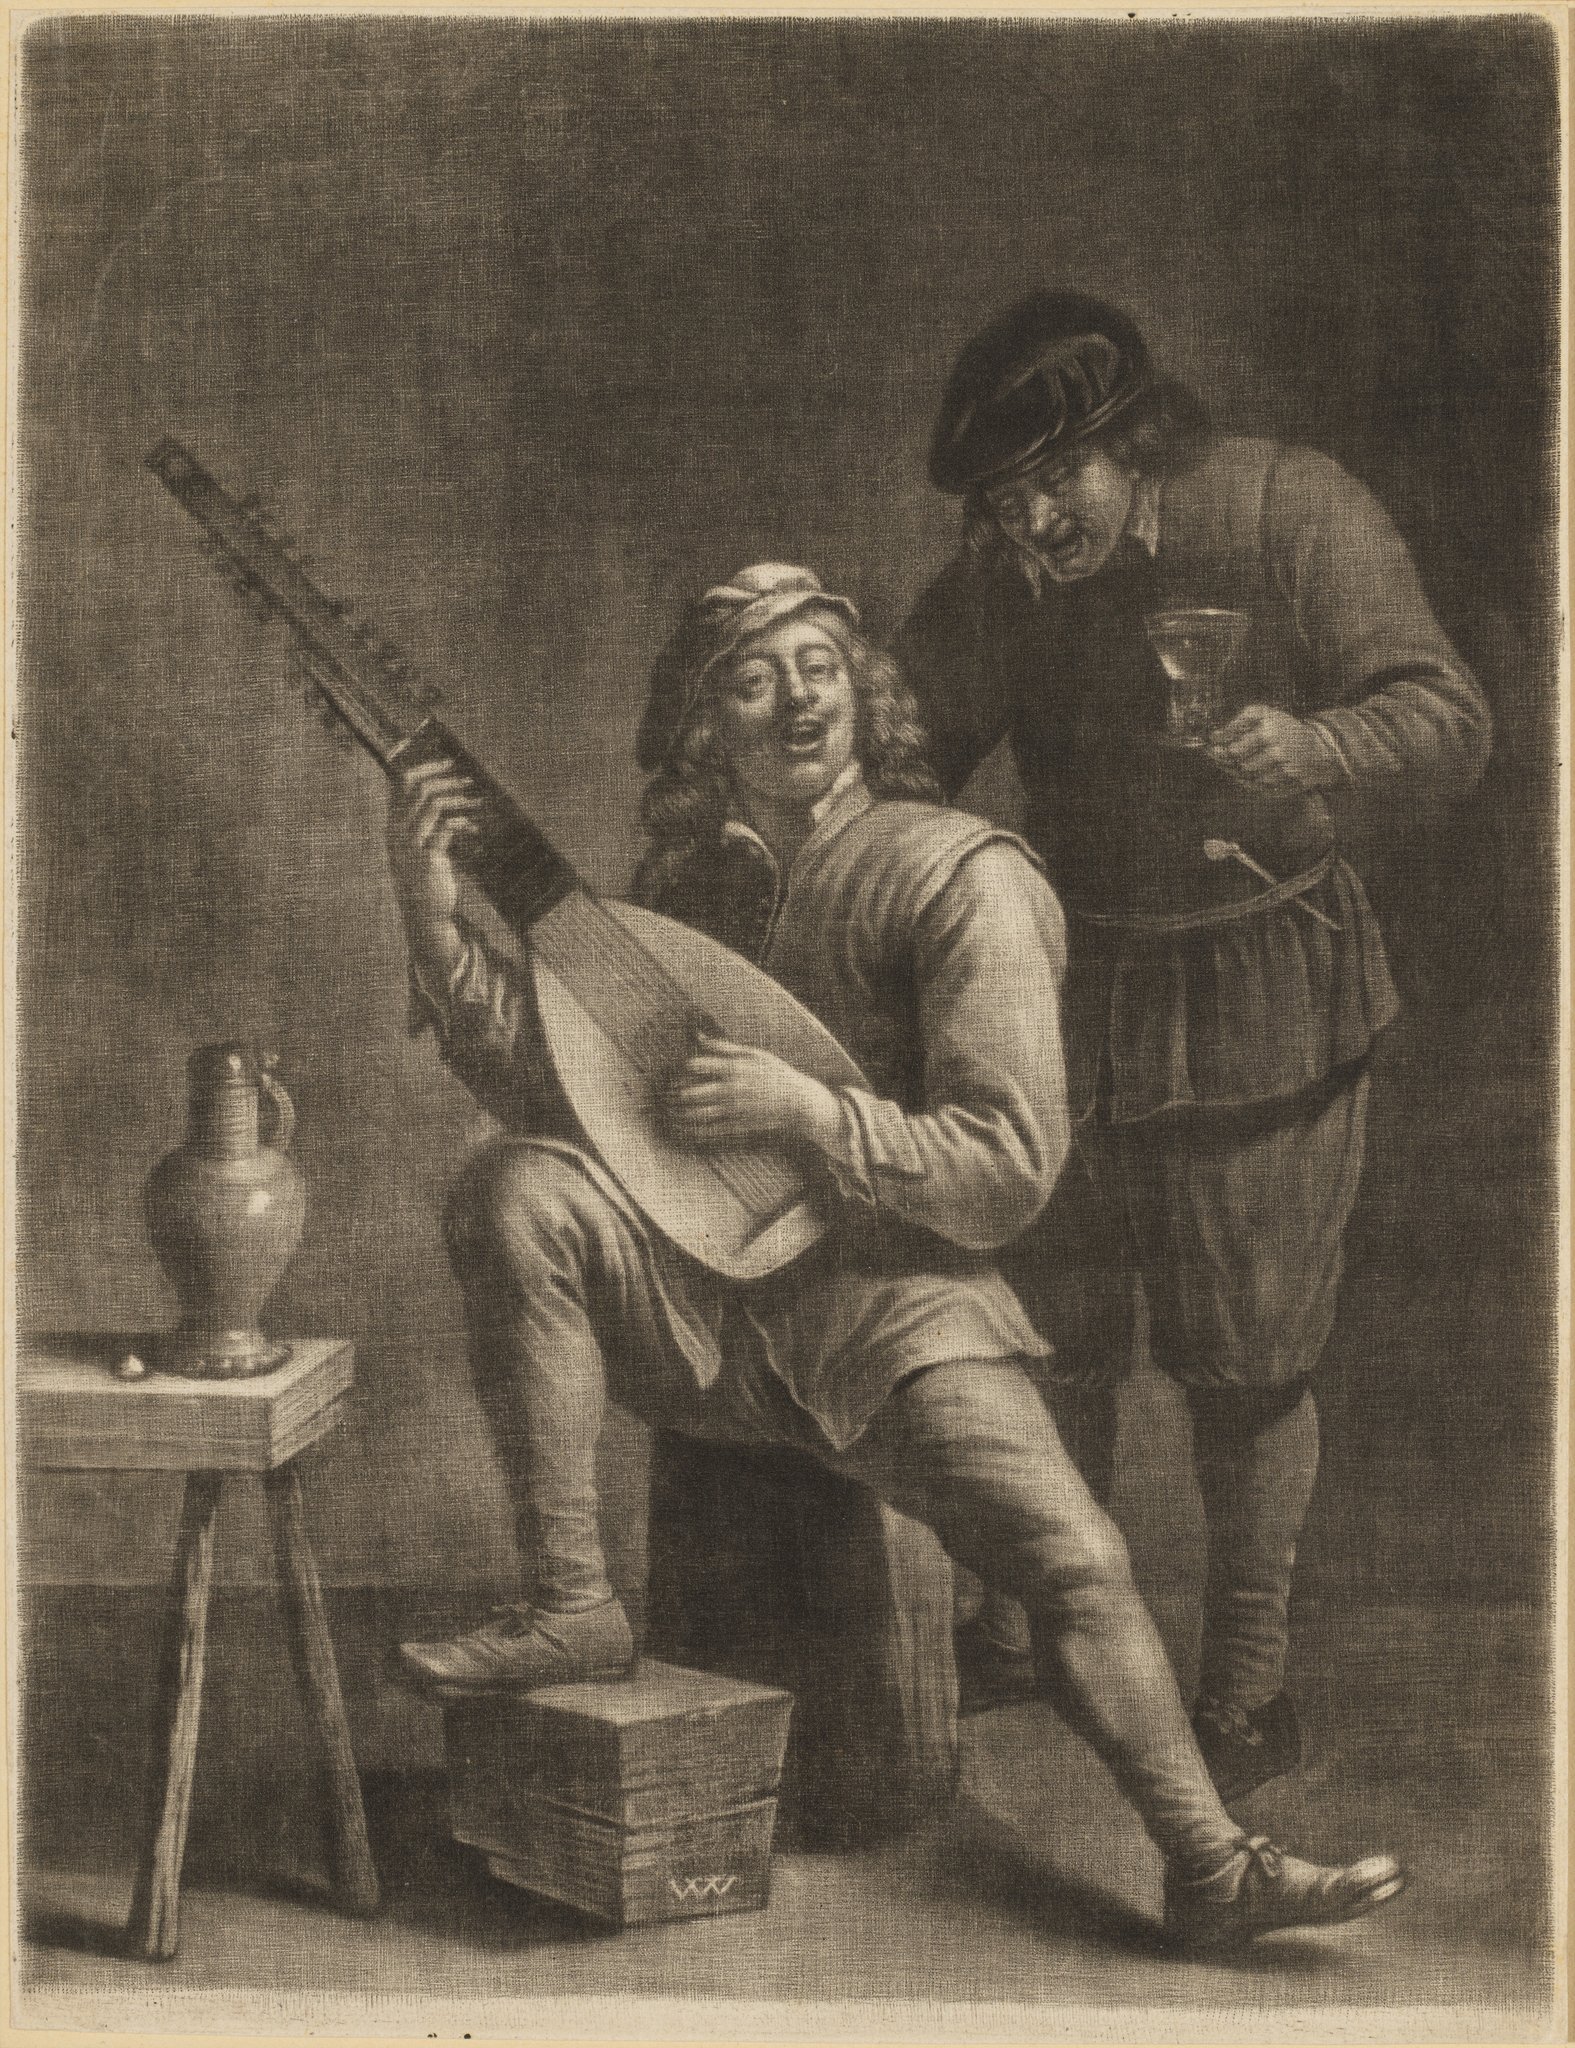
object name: print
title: Lute-Player and a Standing Man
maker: wallerant vaillant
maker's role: artist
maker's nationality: dutch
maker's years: 1623-1677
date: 1601-1700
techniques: mezzotint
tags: musical instruments,men,lutes,musicians